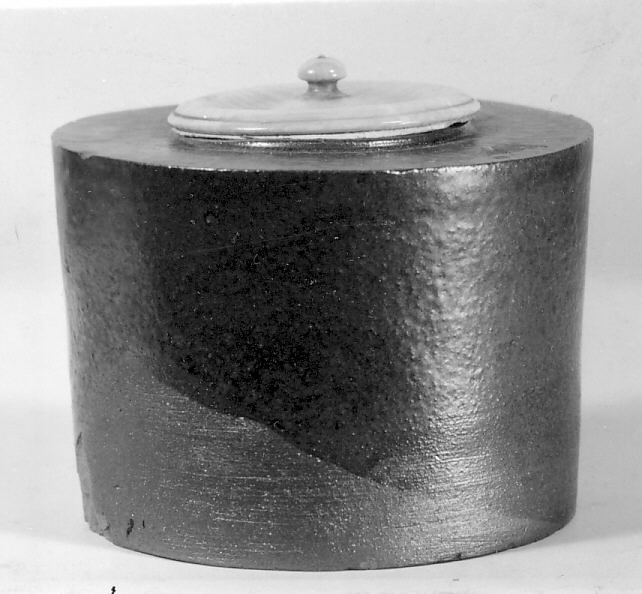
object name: tea jar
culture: japanese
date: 1701-1800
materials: clay, glaze